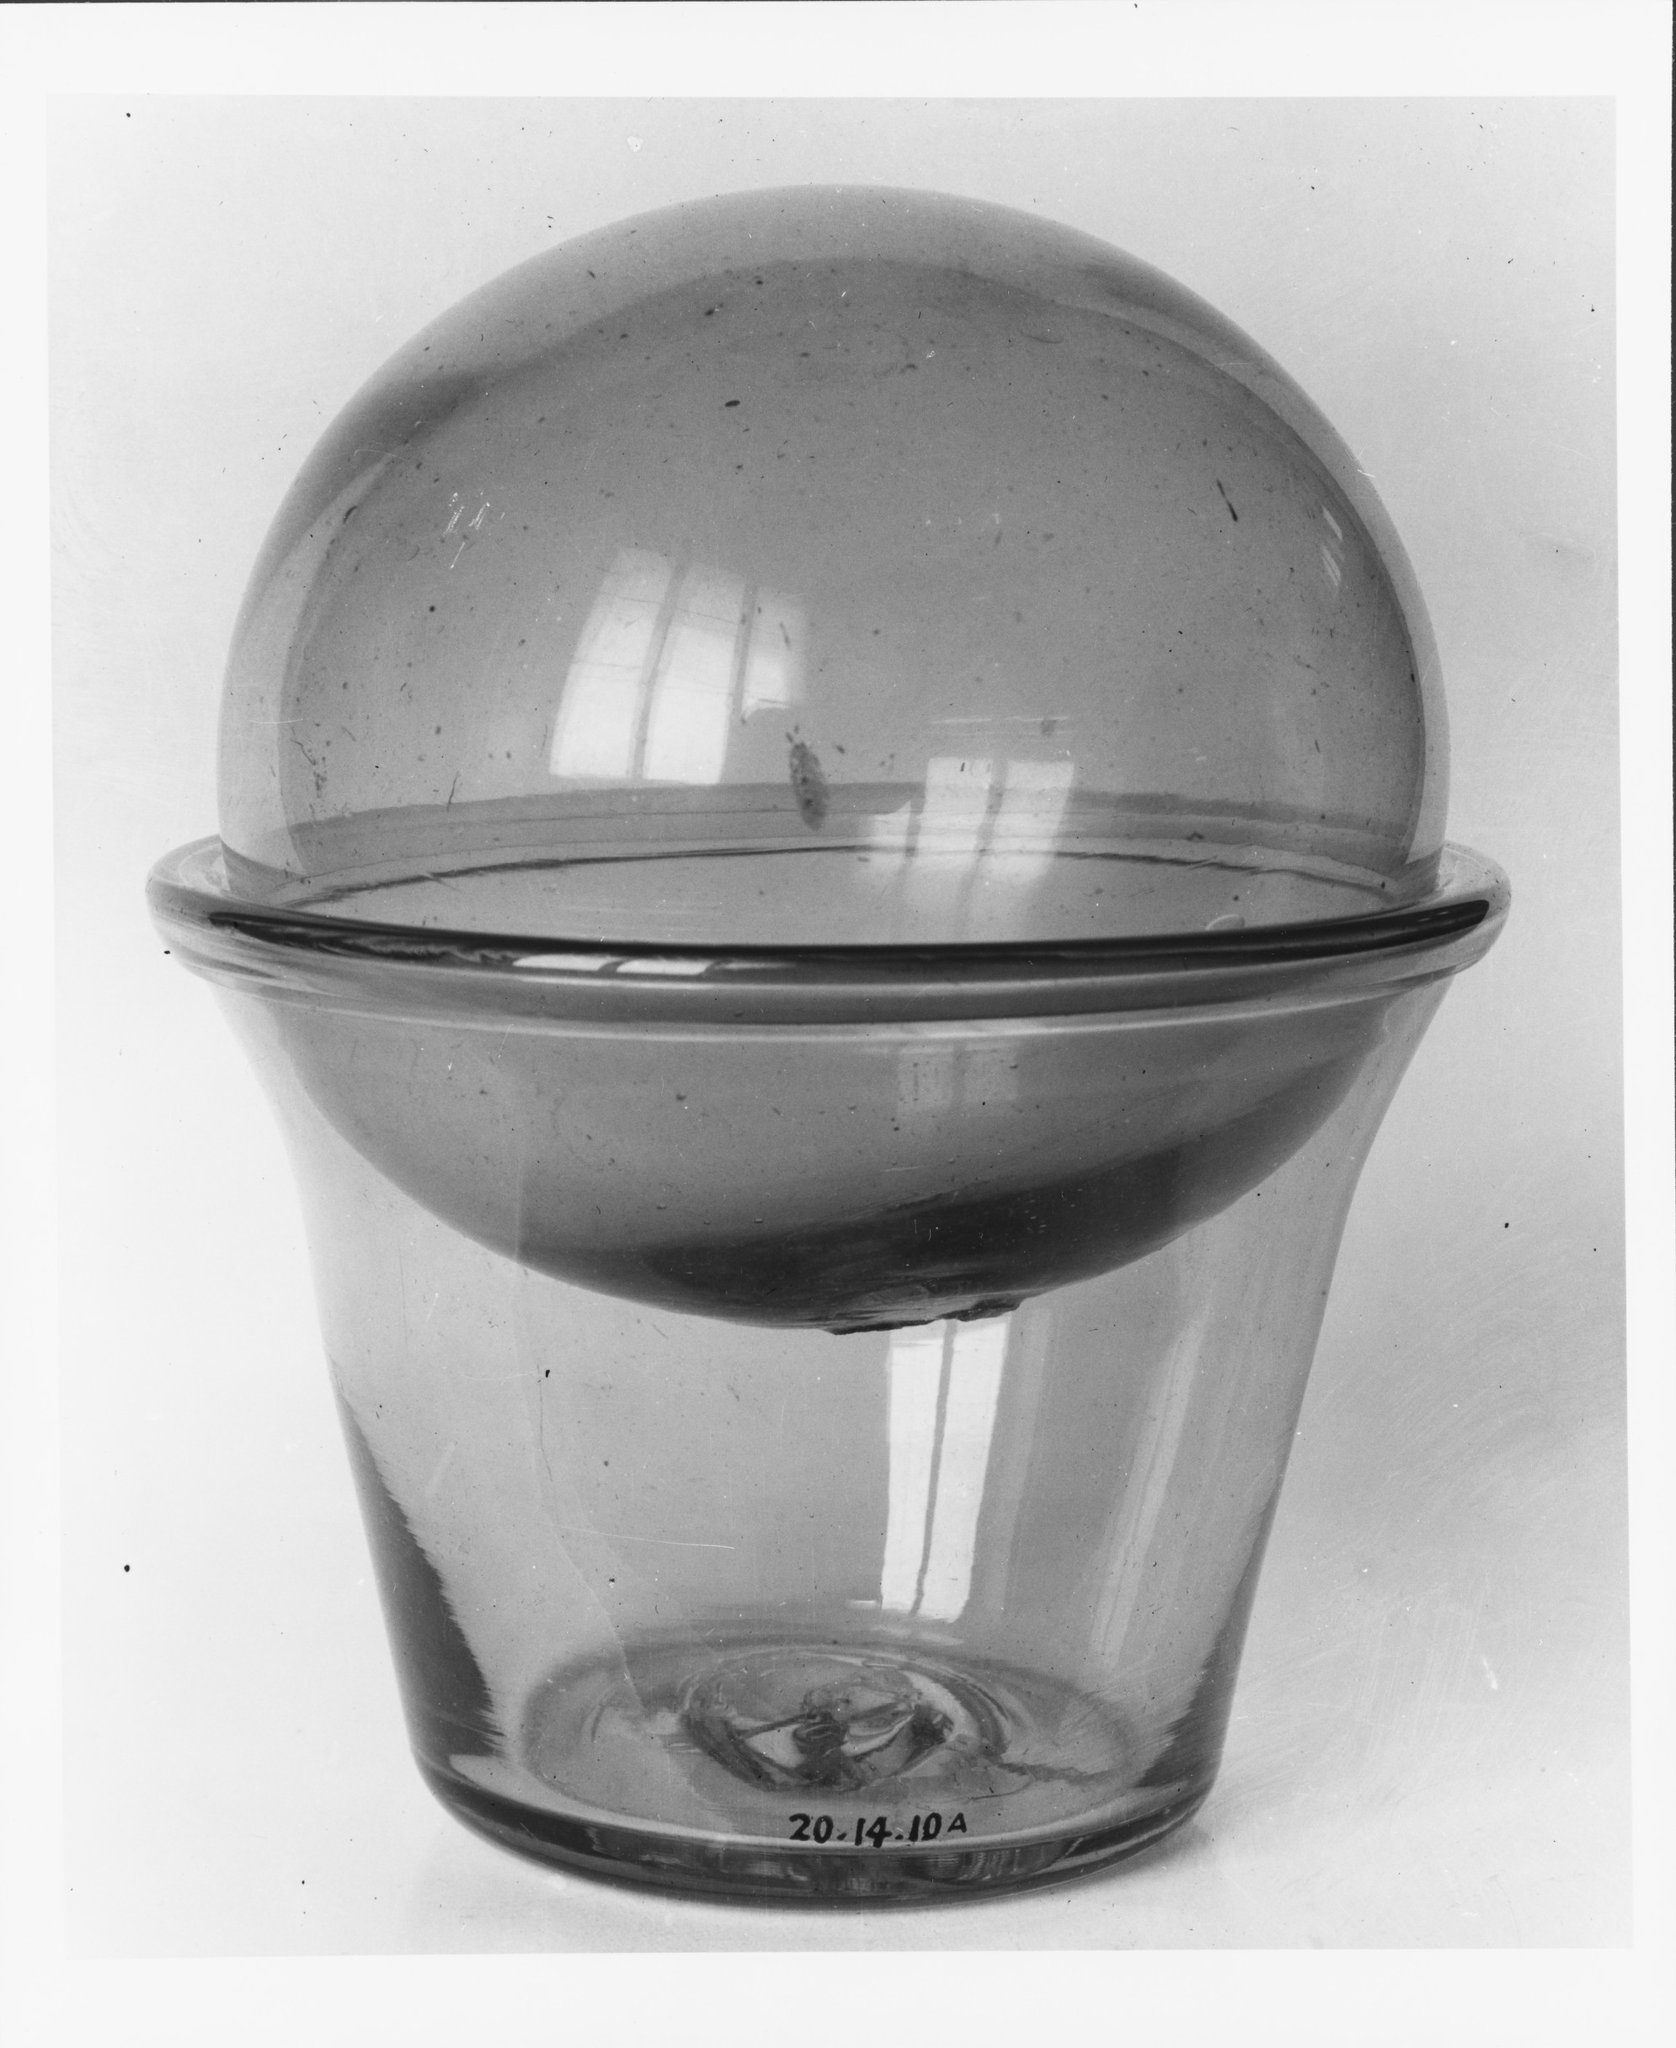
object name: bowl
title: Covered Bowl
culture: american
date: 1801-1900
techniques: glassblowing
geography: united states